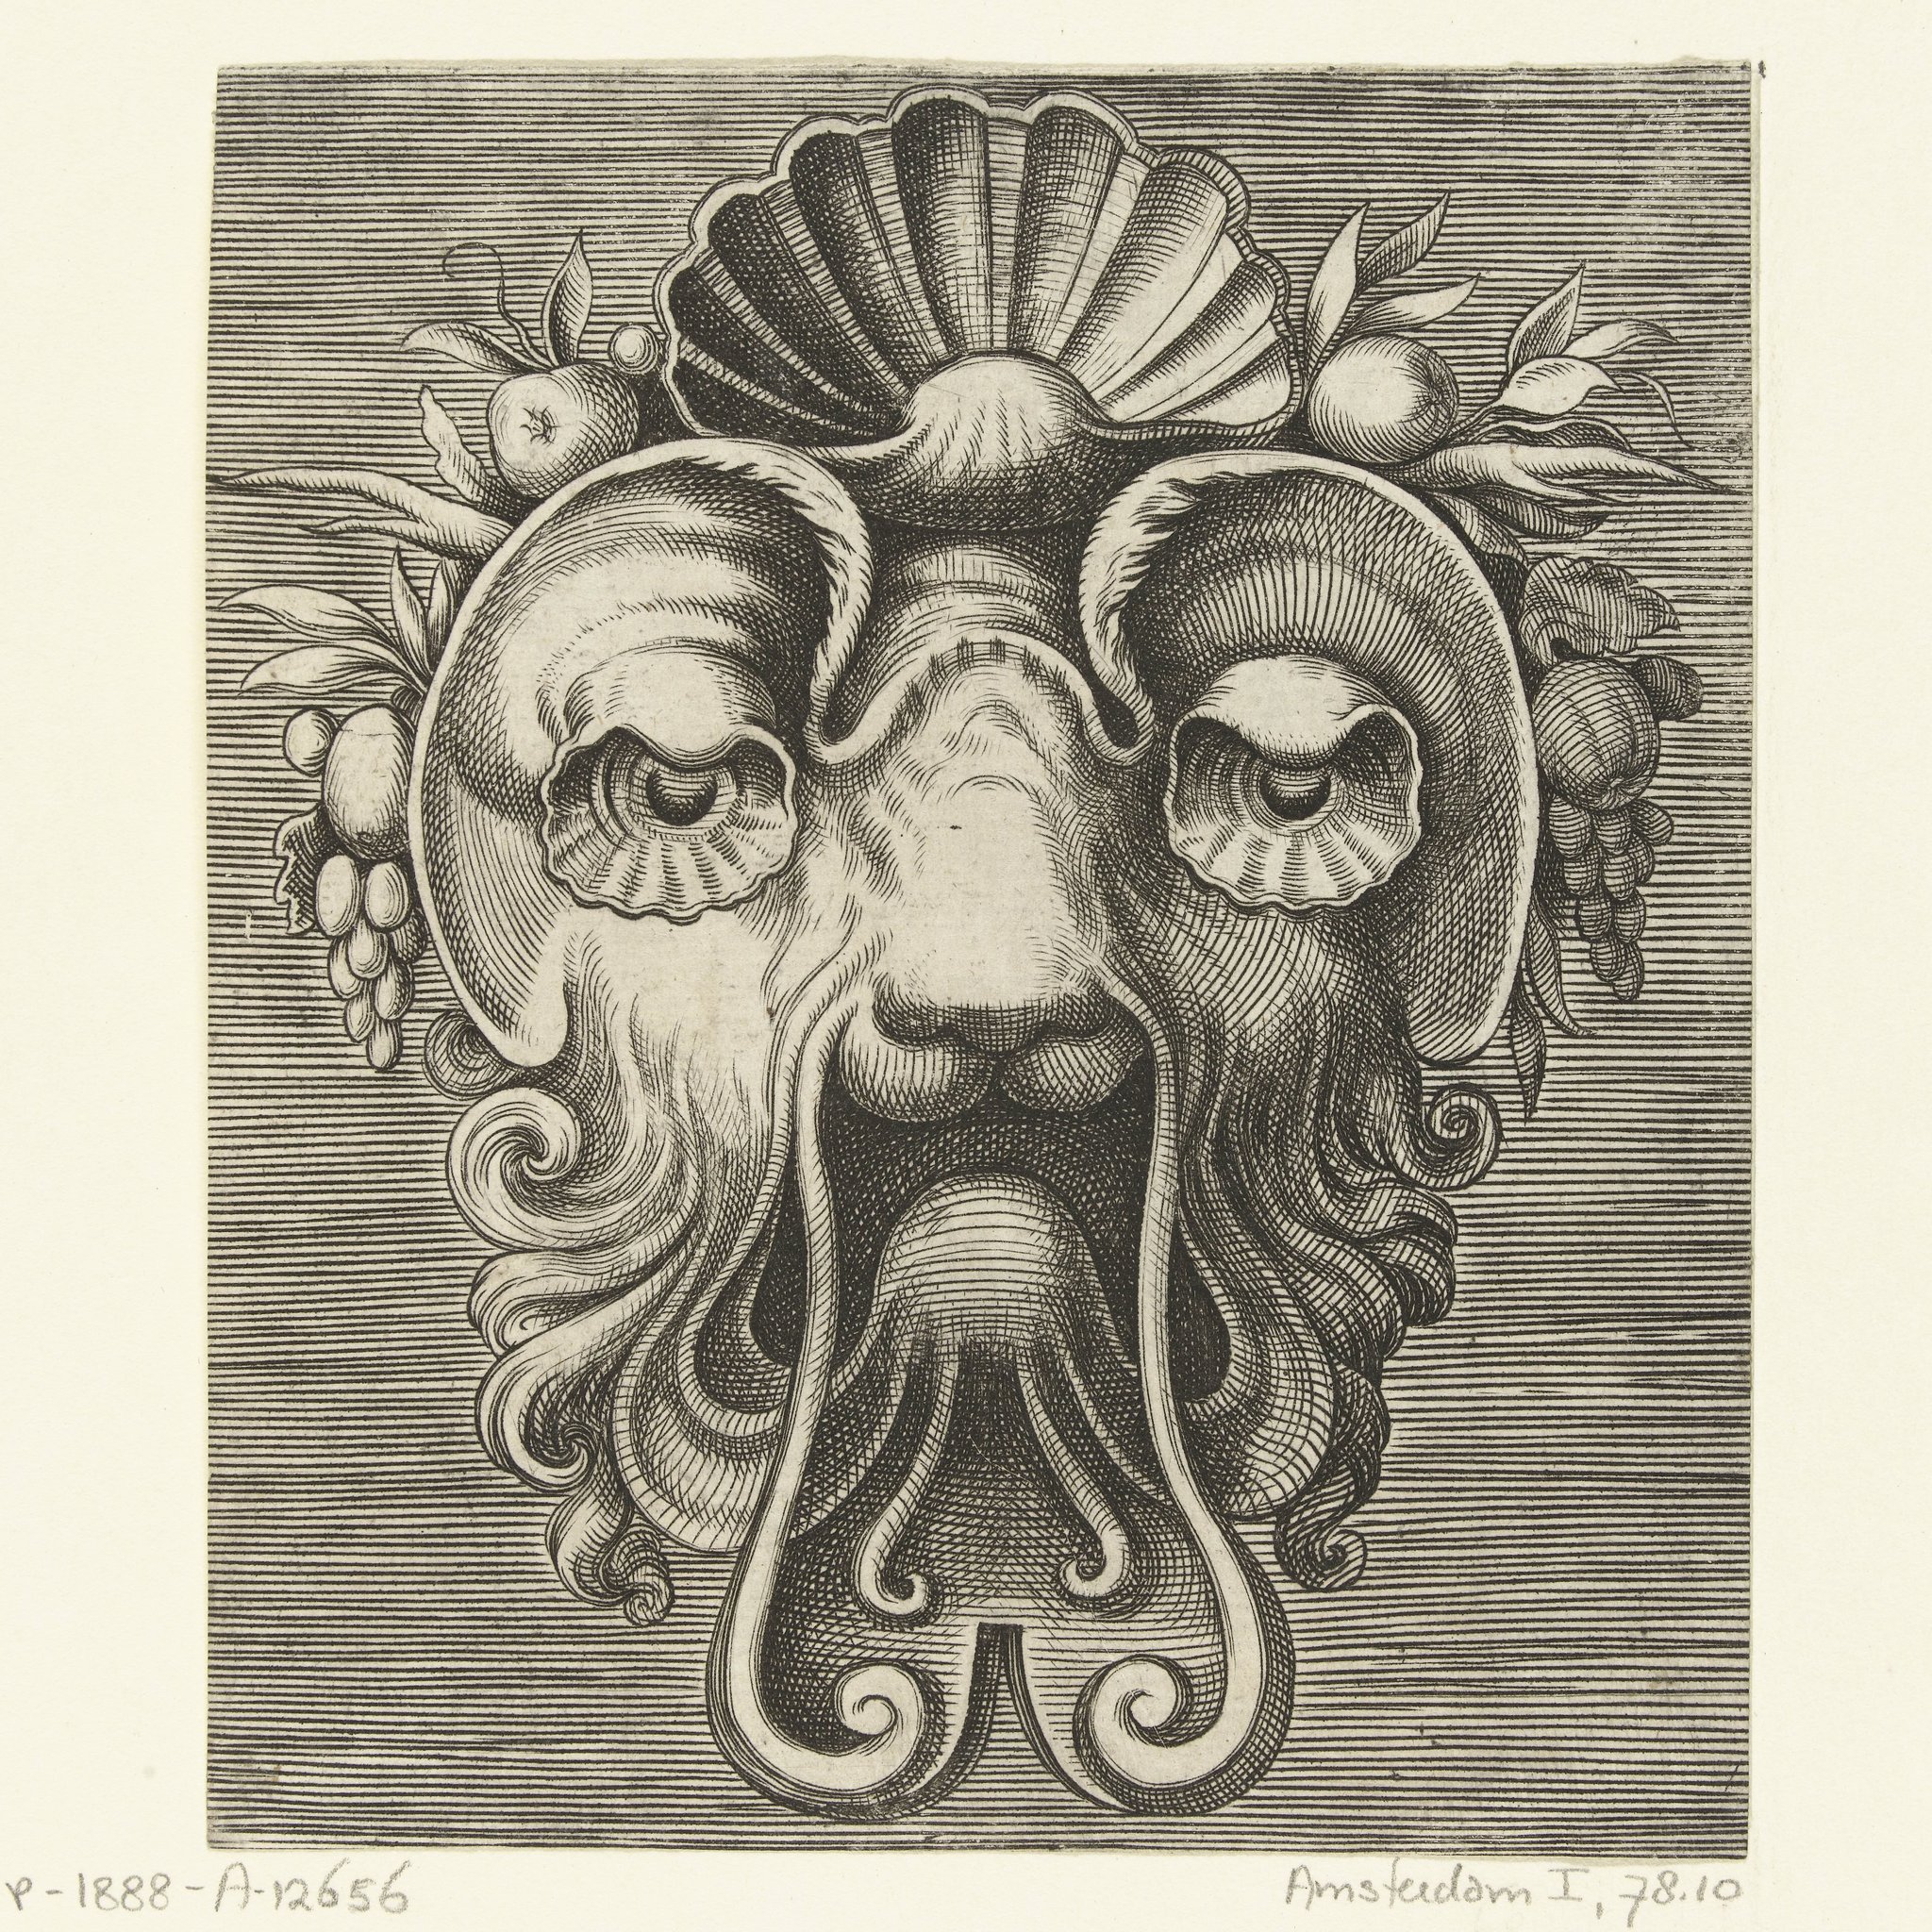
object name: print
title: Masker met schelpvormige ogen en een schelp tussen vruchtentrossen op het voorhoofd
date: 1555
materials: paper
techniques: engraving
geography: antwerp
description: Een van 14 bladen uit een serie van 18 met als titel 'Pourtraicture ingenieuse de plusieurs façons de masques...'. Het titelblad ontbreekt.